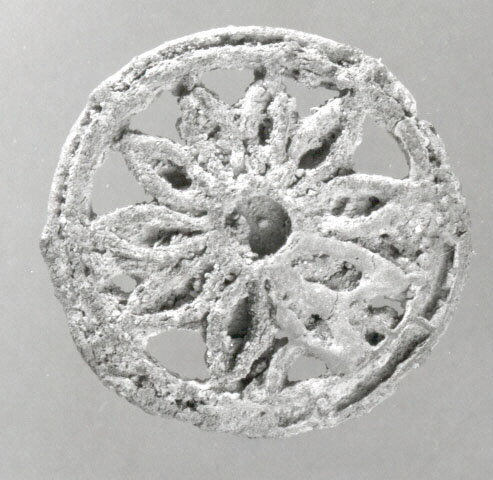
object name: stamp seal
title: Compartmented stamp seal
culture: bactria-margiana archaeological complex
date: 2333-1668 BCE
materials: copper alloy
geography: bactria-margiana